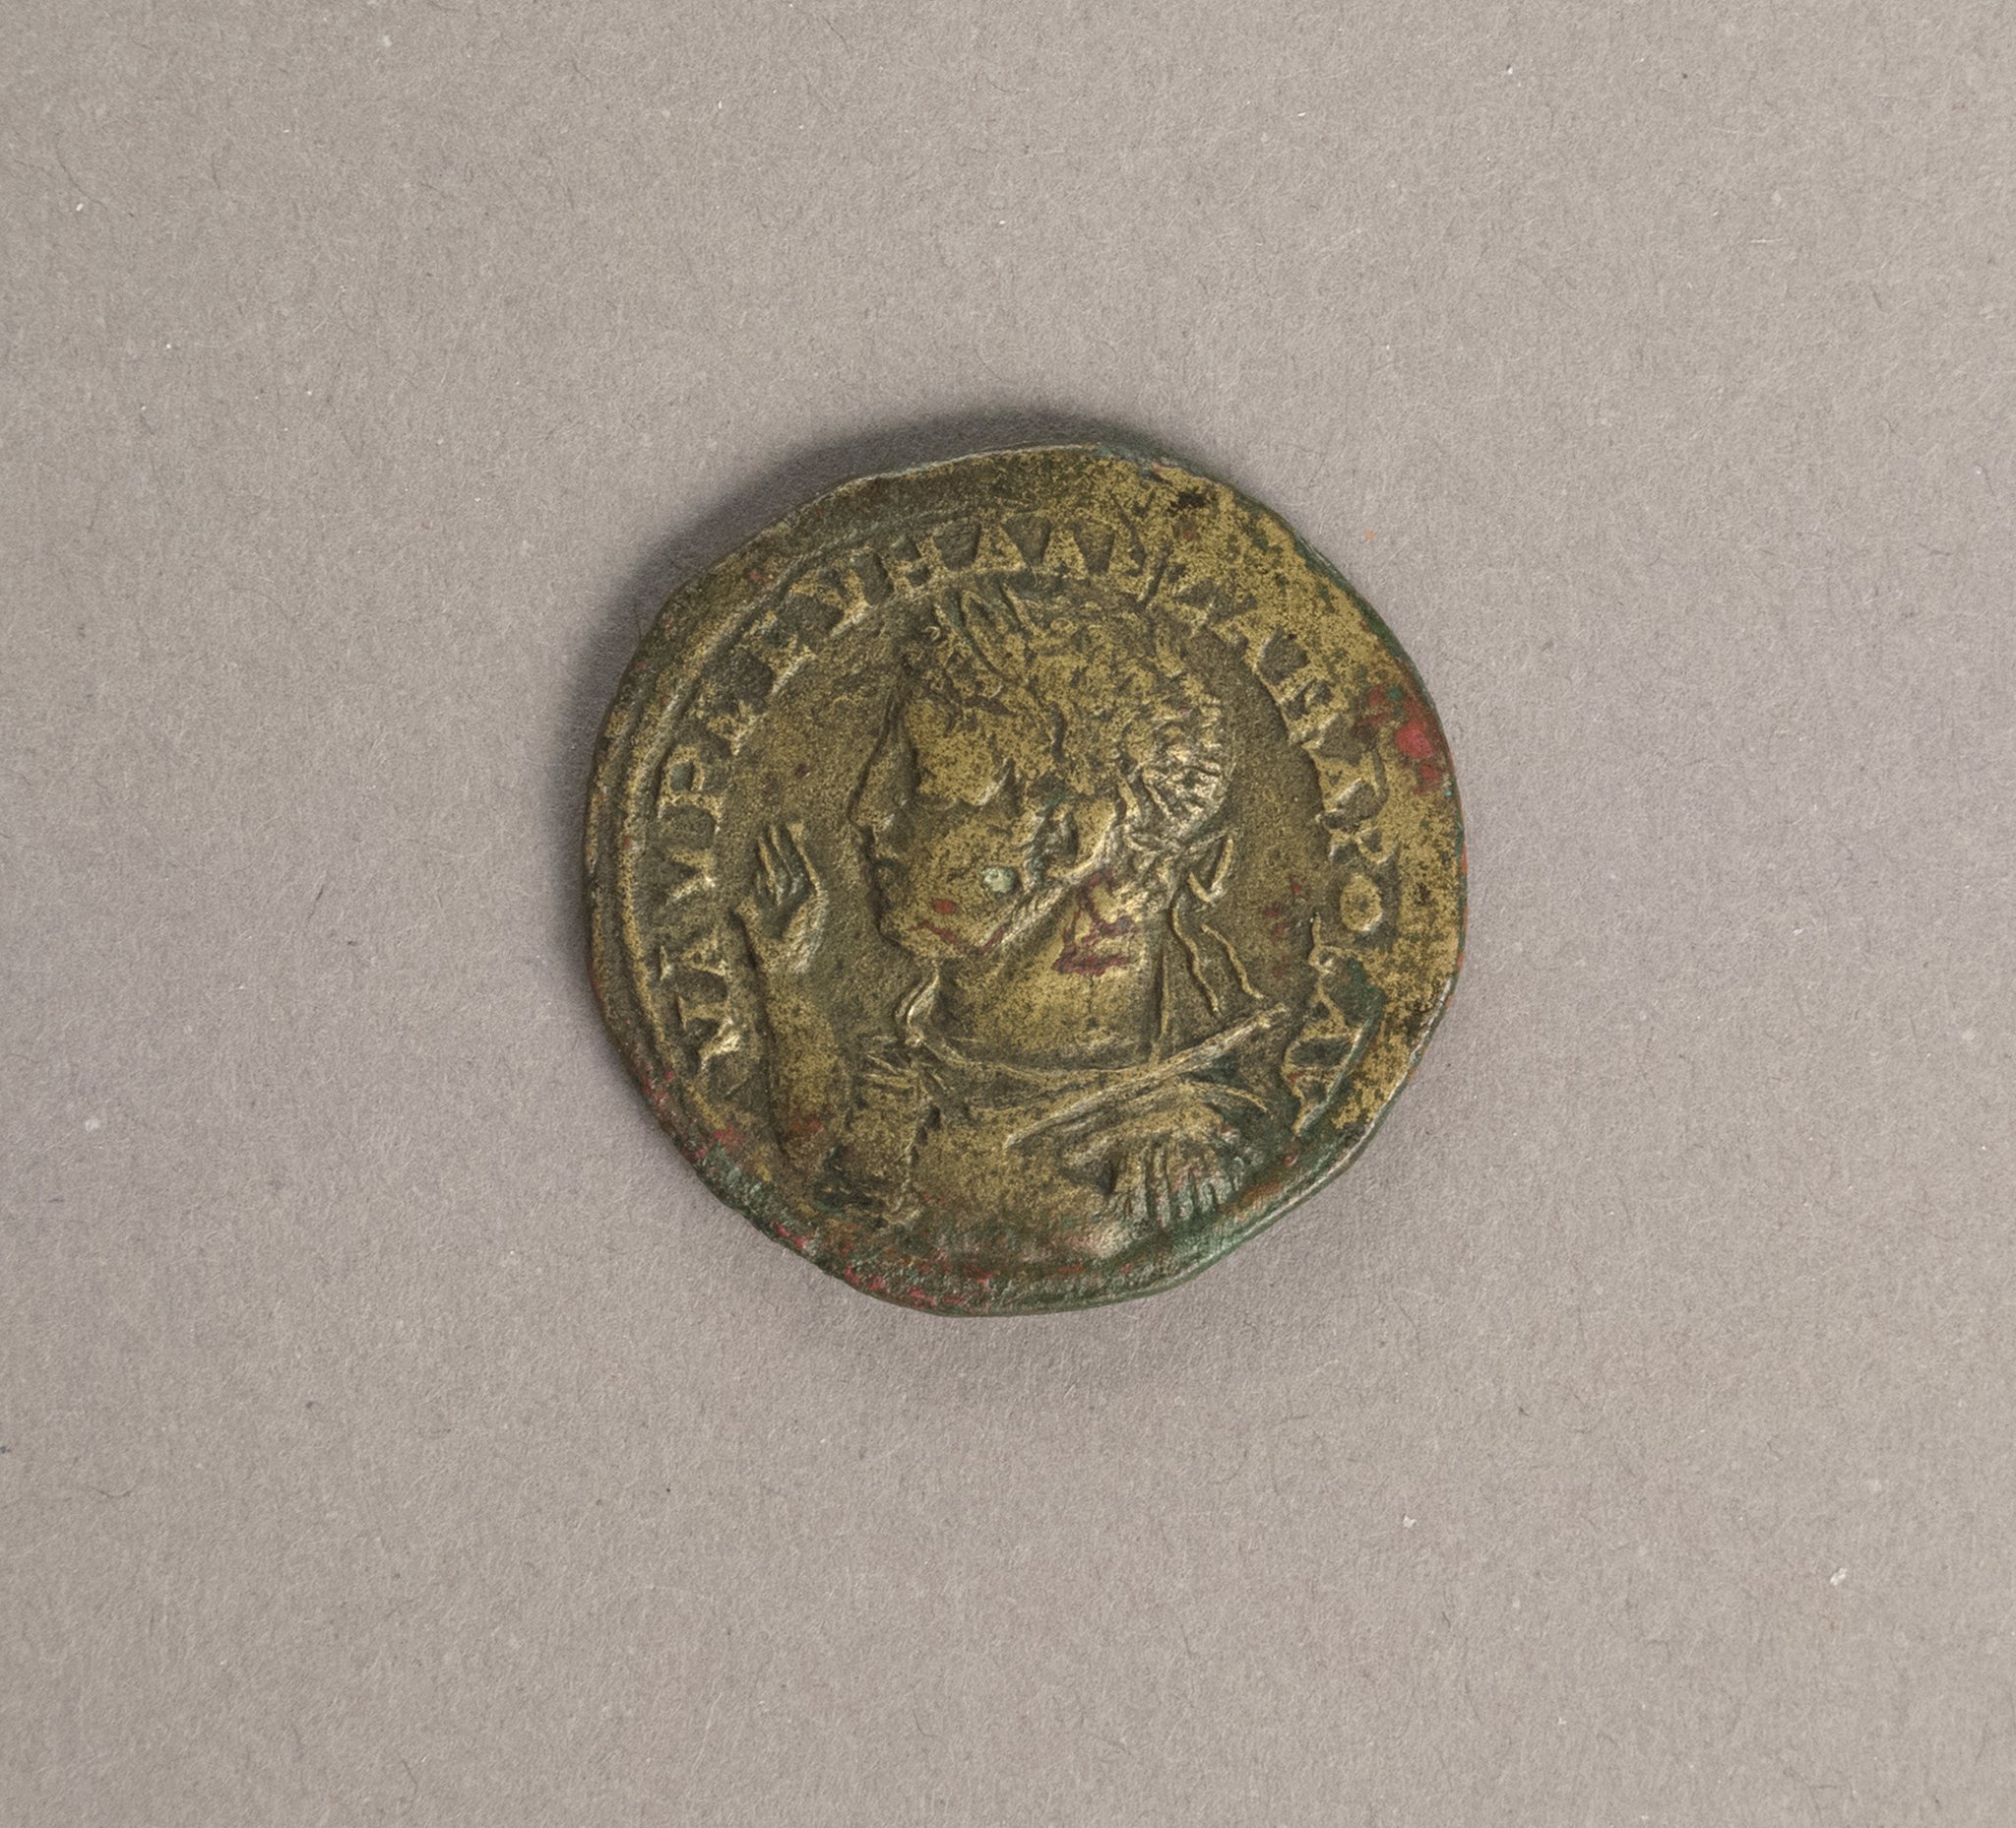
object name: provincial issue of cyzicus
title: Bronze coin of Cyzicus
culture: roman, asia minor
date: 222-235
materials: bronze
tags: men,profiles